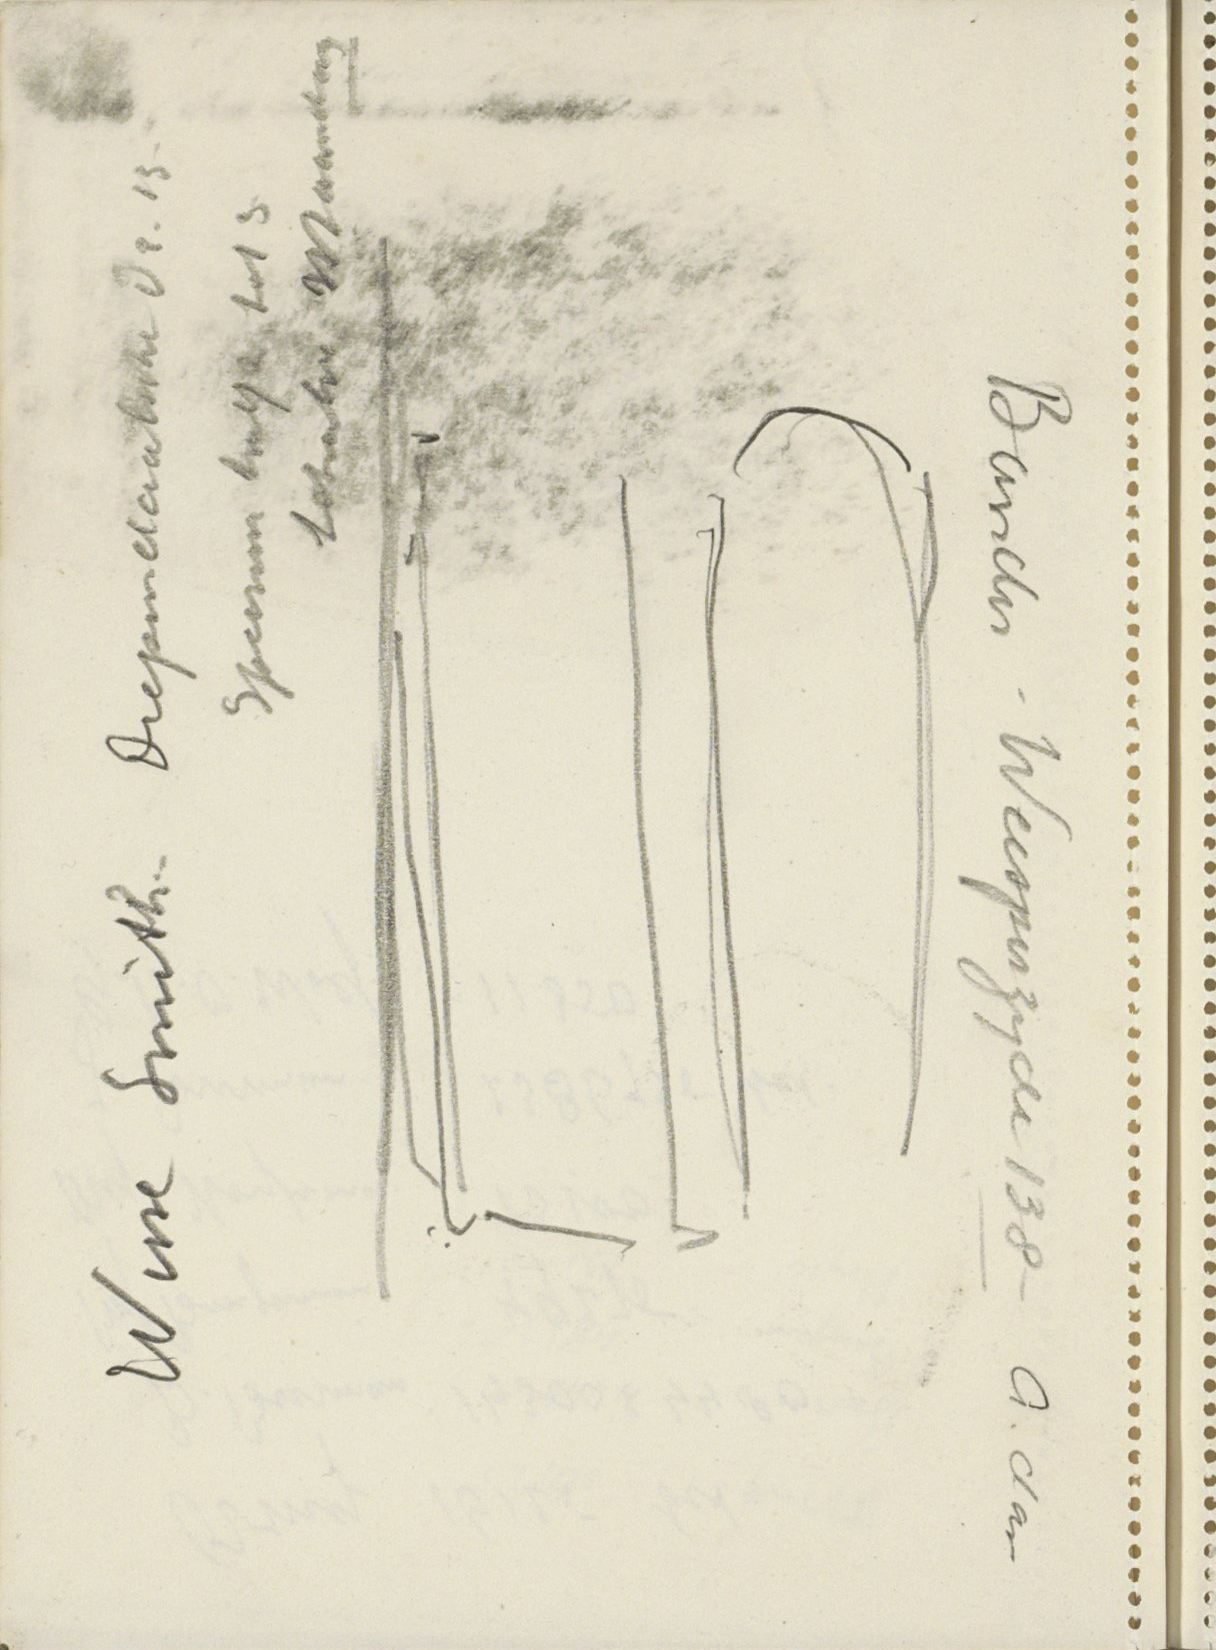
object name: sketchbook leaf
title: Studie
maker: cornelis vreedenburgh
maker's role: draughtsman, print maker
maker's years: 1880-1946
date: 1890-1946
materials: paper, pencil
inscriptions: annotation: ‘Band[...] Weesperzijde 138 Adam/ Wine Smith Diependaalsche Dr. 13/ [...]’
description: Blad 70 verso uit een schetsboek met 71 bladen.